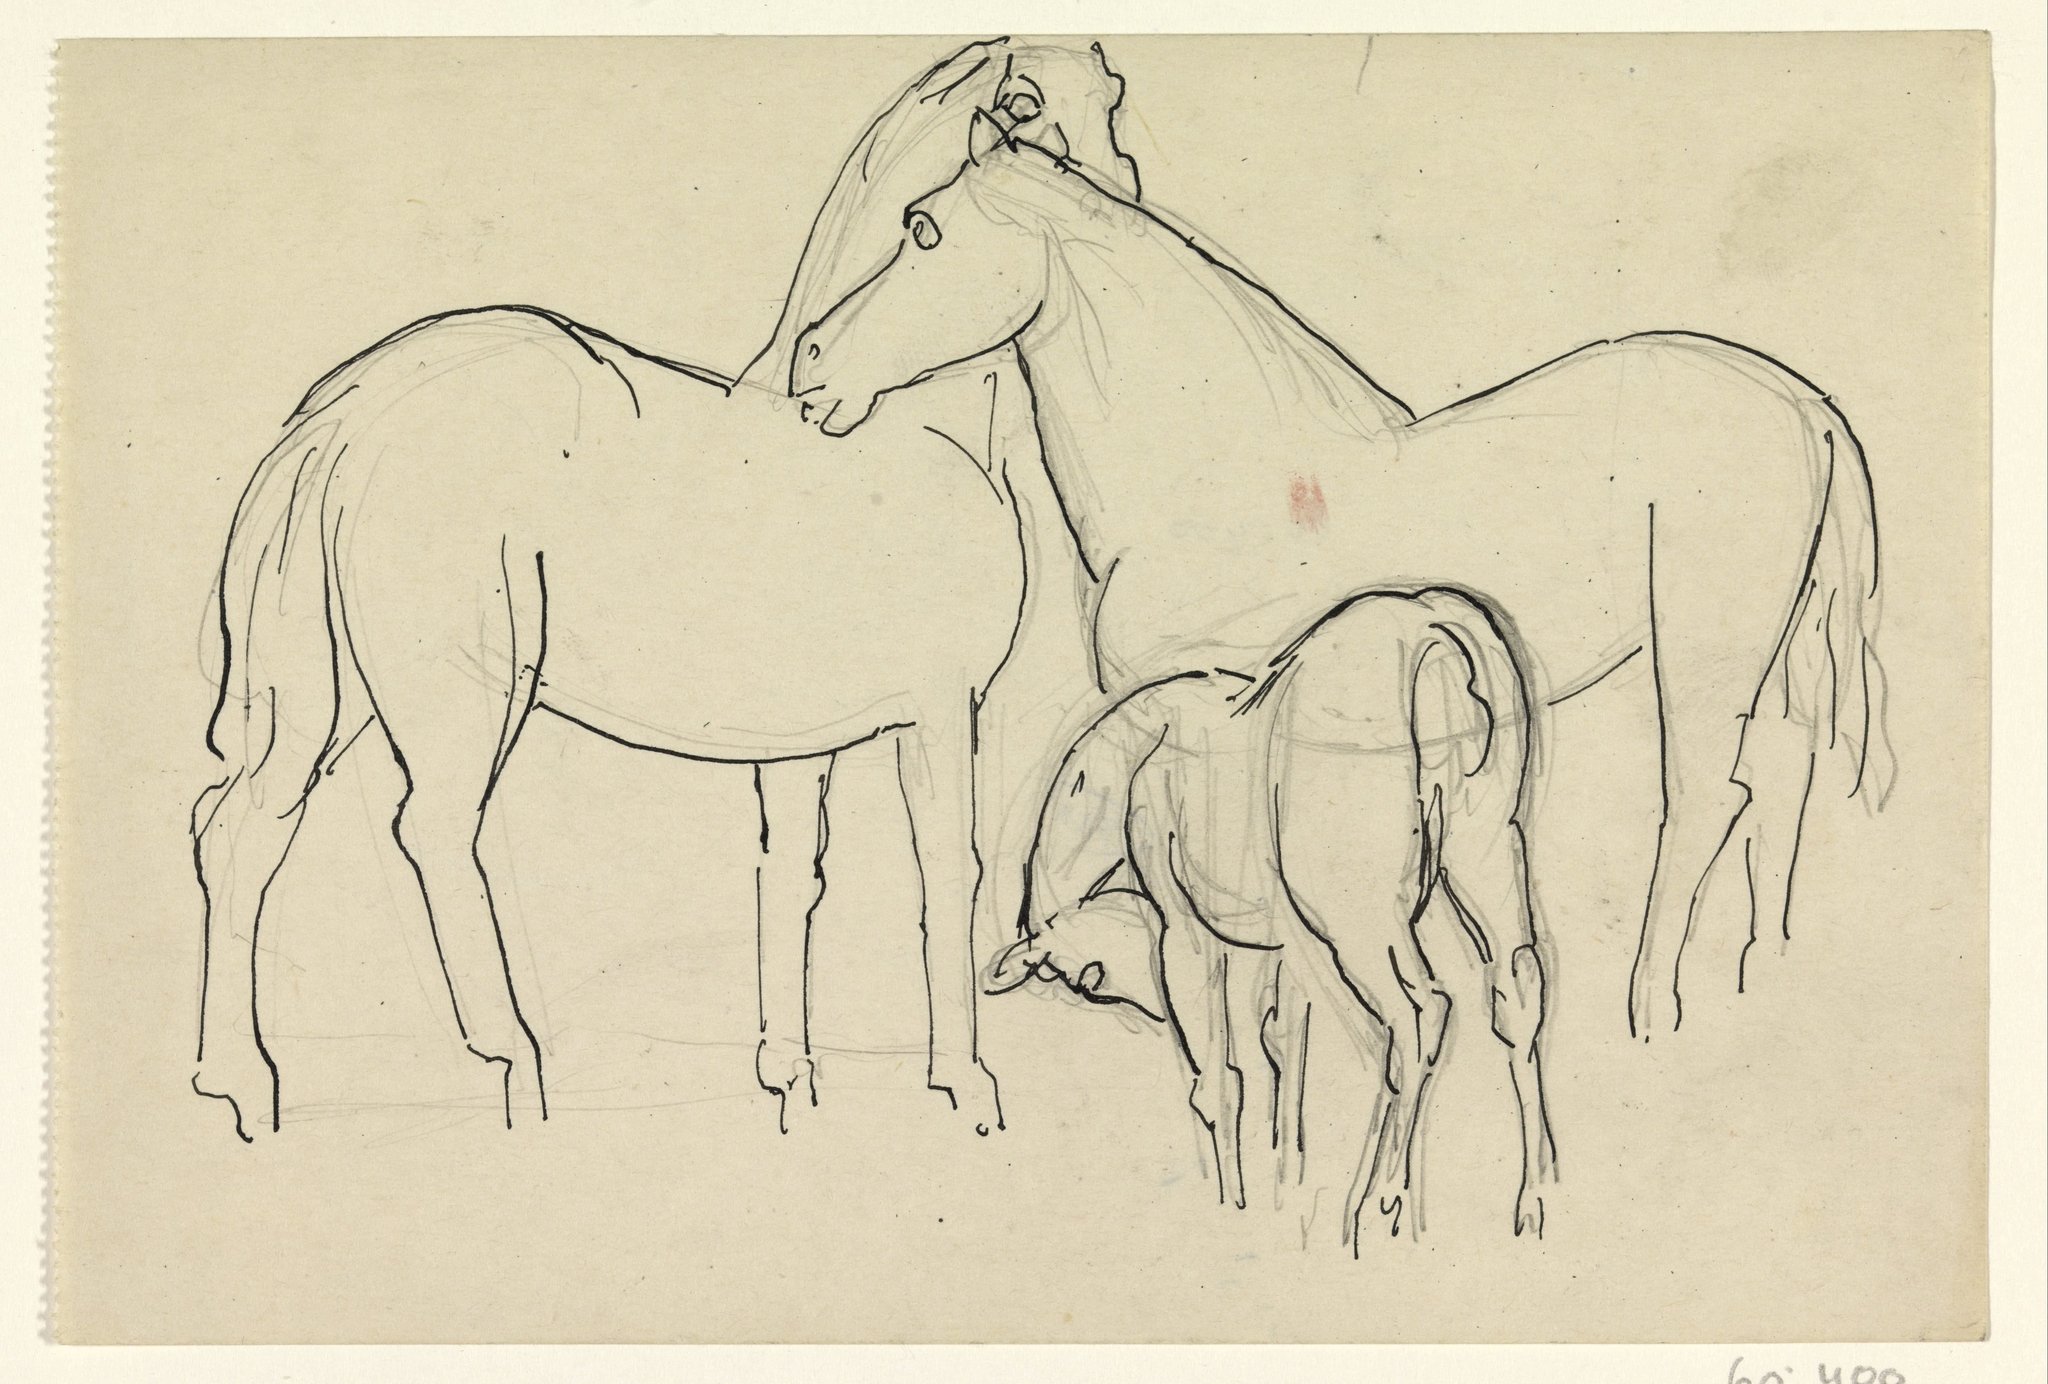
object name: drawing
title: Twee paarden en een veulen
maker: leo gestel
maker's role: draughtsman, print maker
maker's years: 1881-1941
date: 1926-1928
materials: ink, paper, pencil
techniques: pen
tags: horse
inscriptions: collector's mark: Lugt 2228